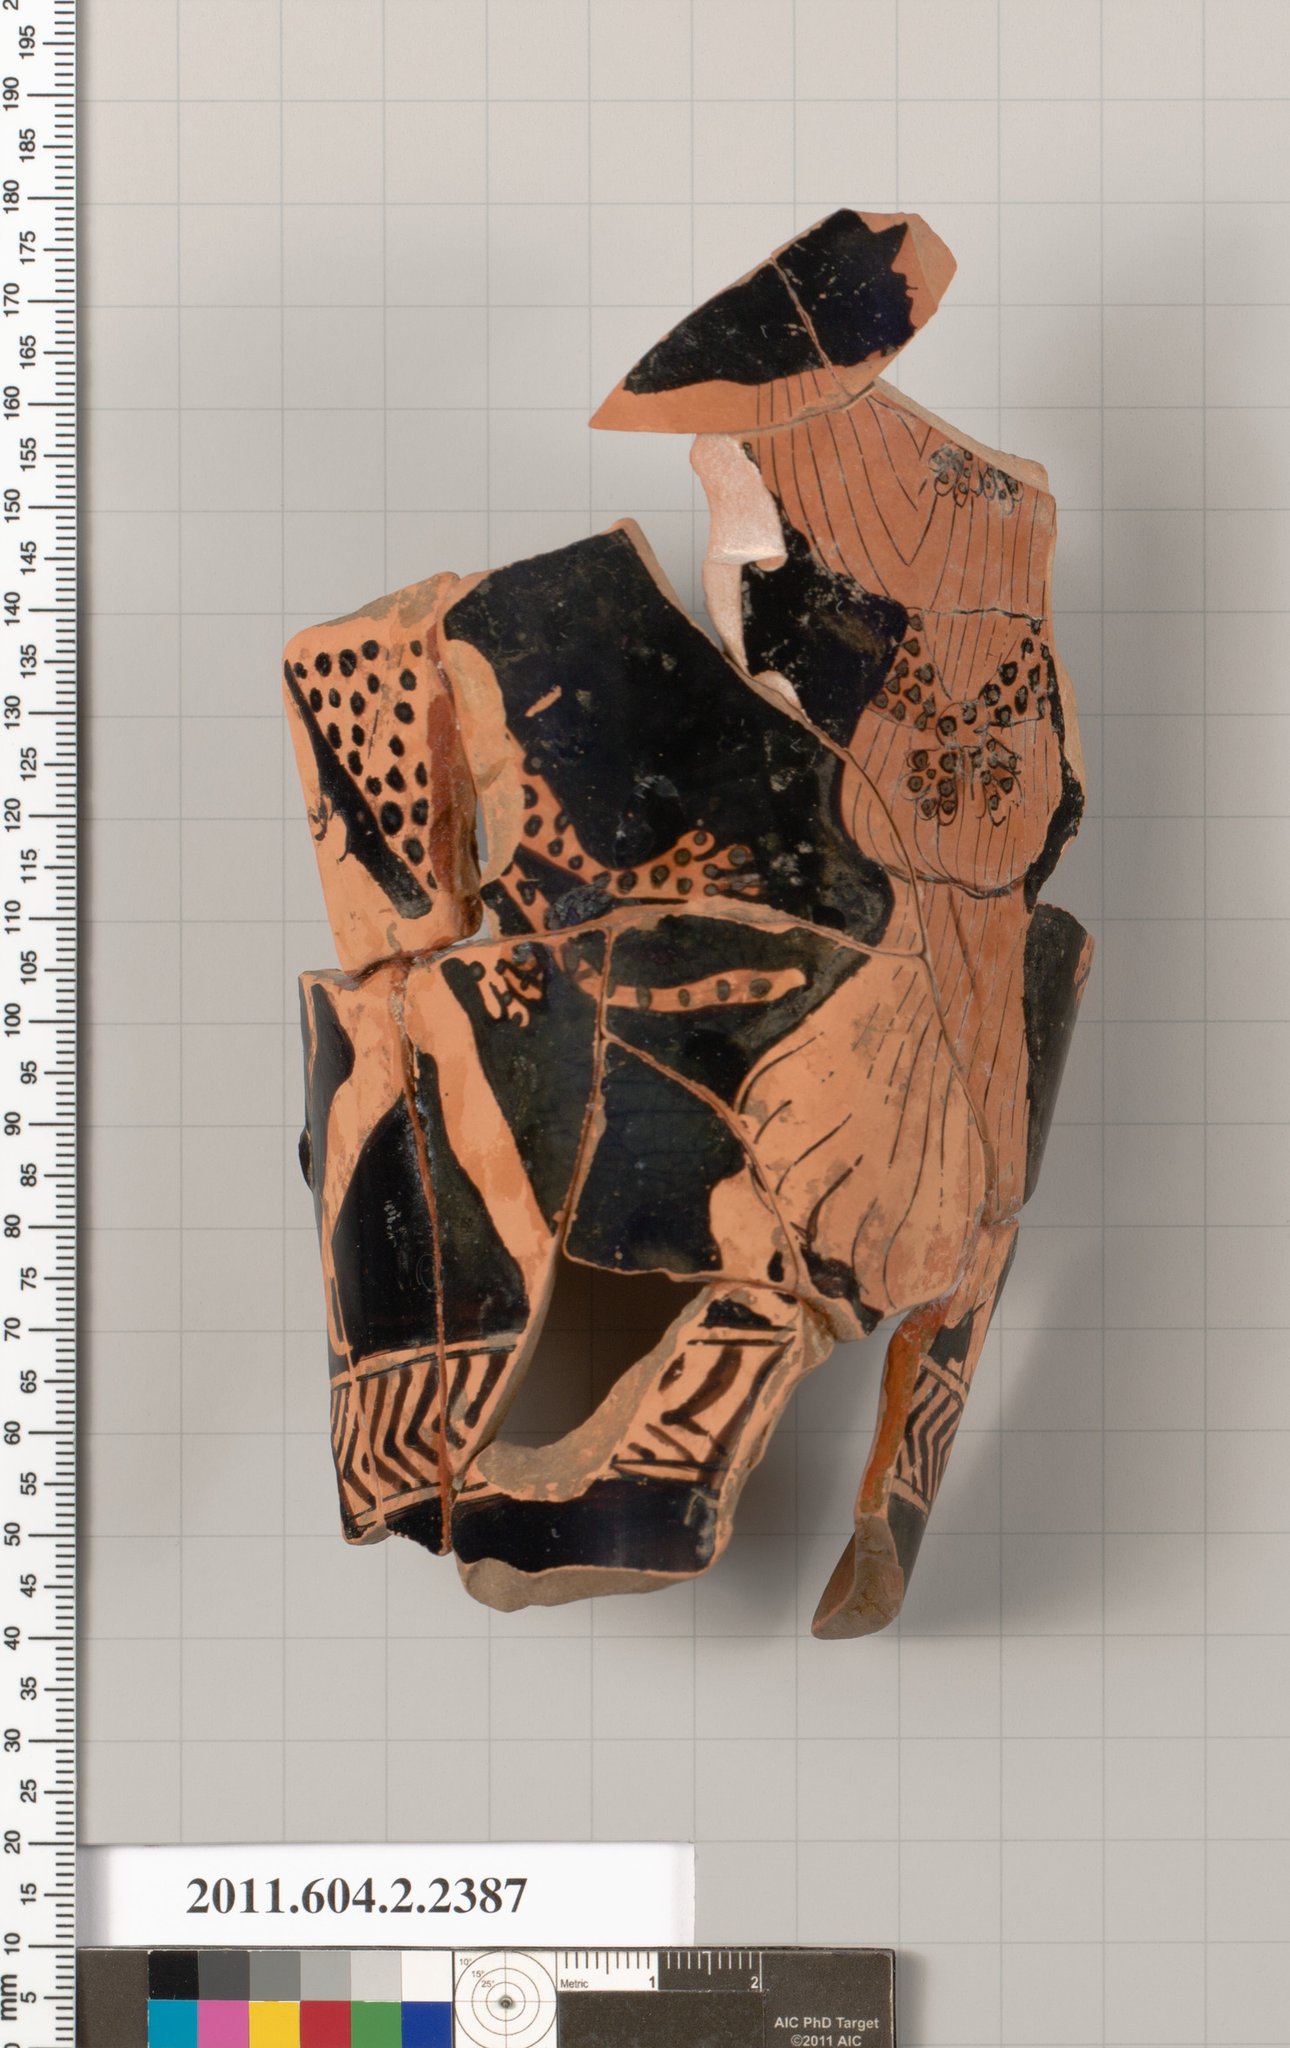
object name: rhyton fragment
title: Terracotta fragment of a rhyton (vase for libations and drinking)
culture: greek, attic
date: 475-451 BCE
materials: terracotta